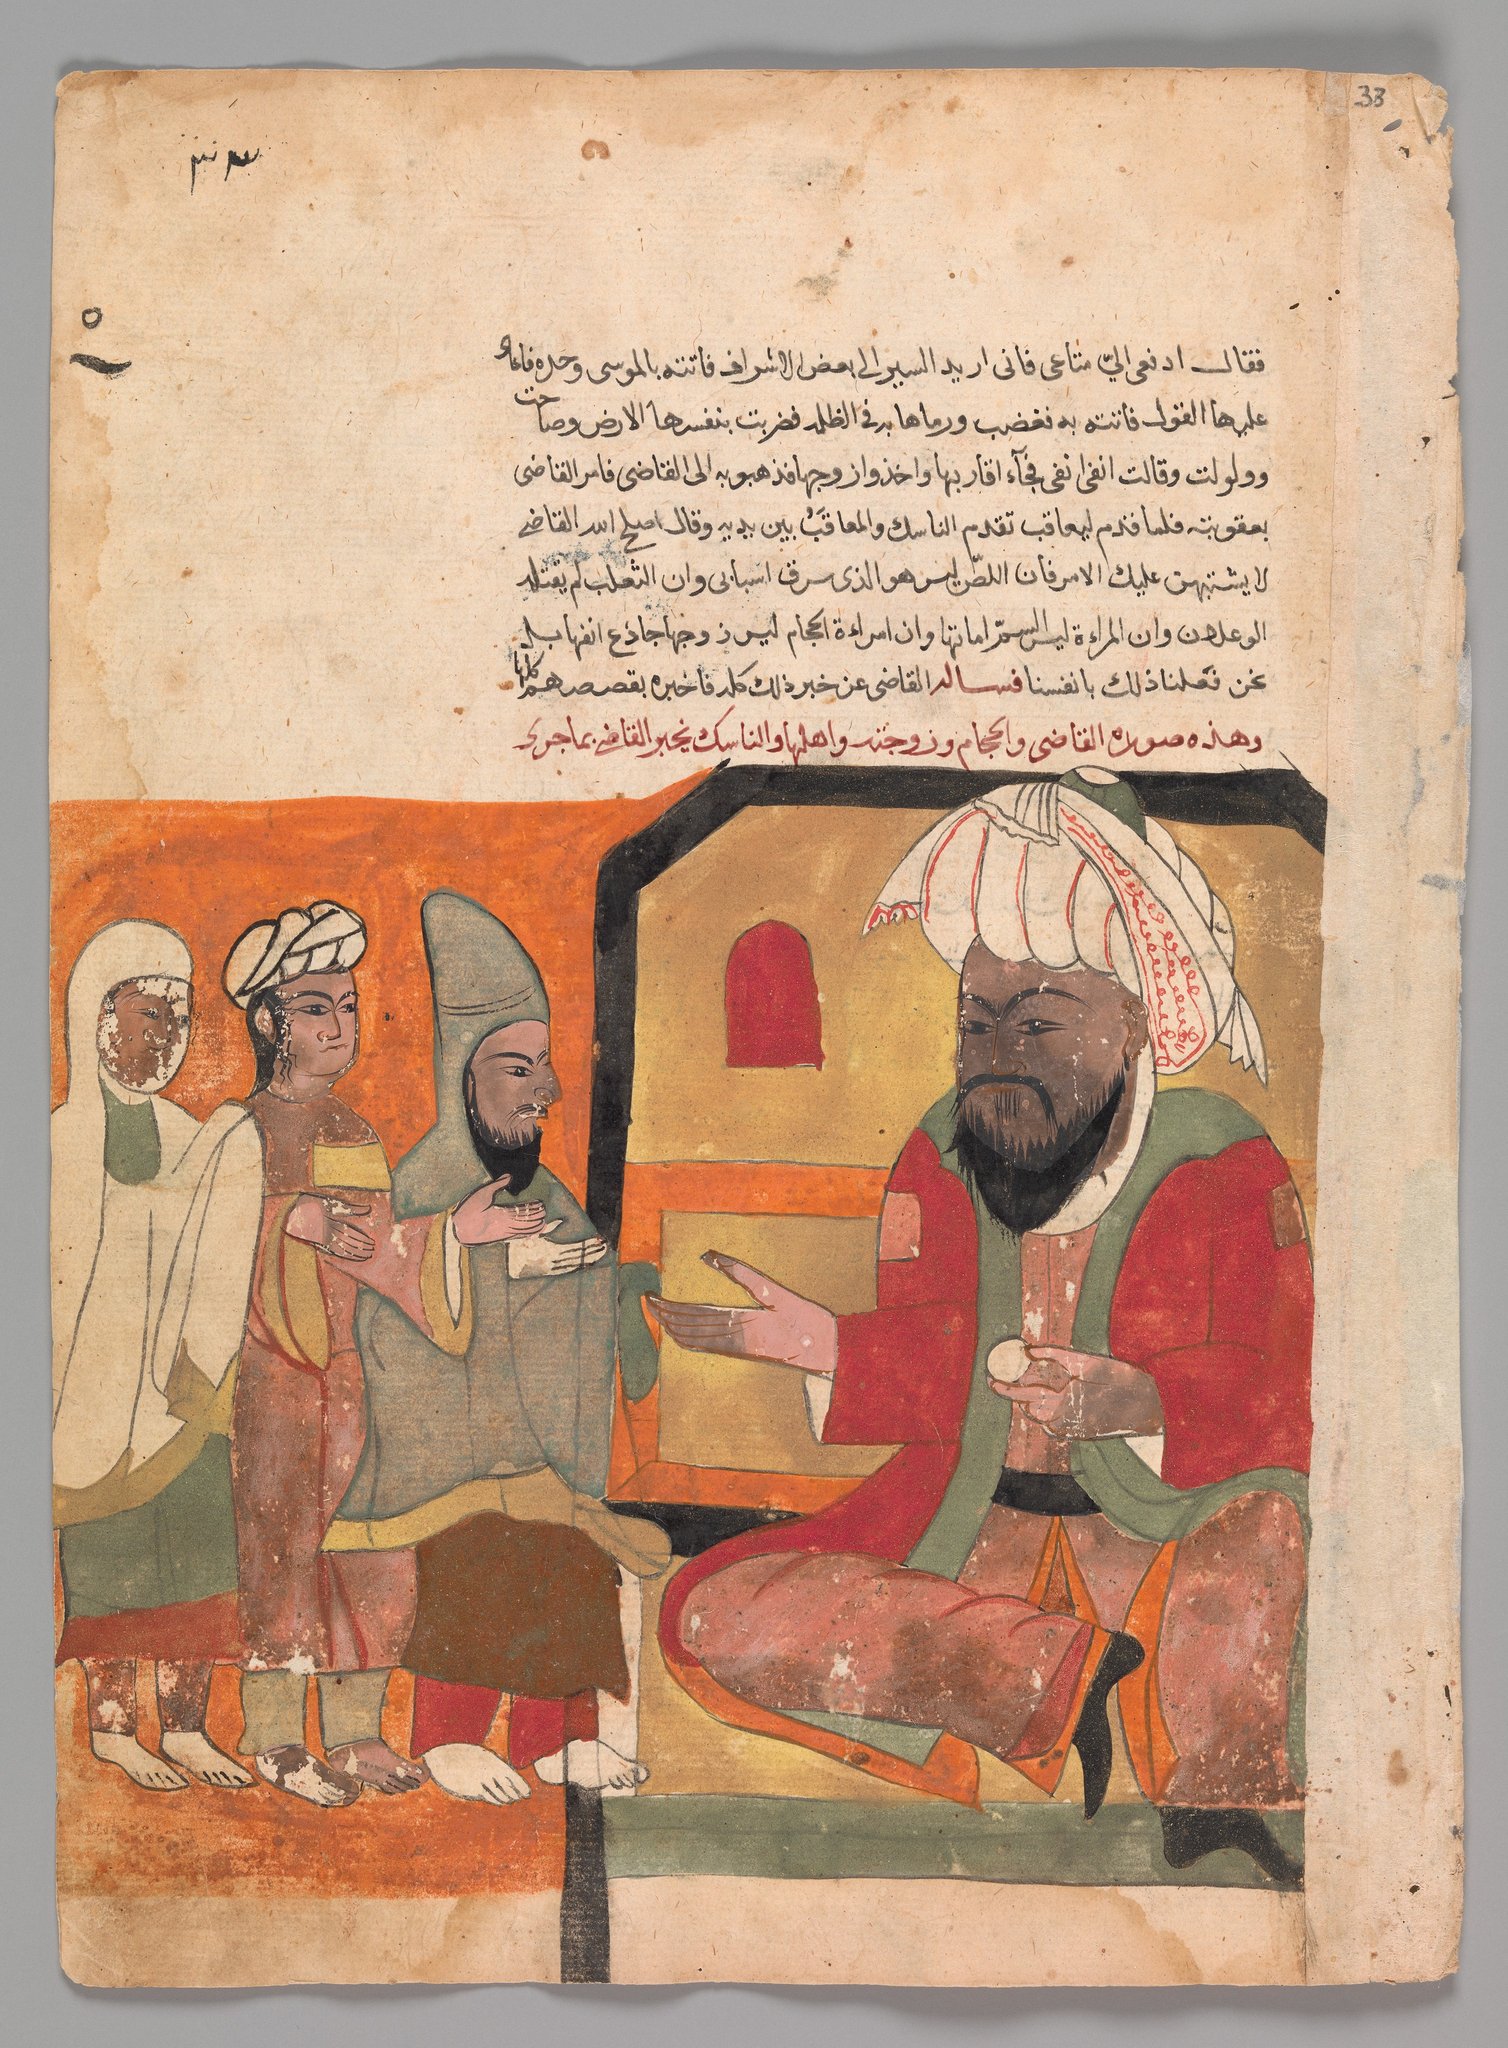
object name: folio from an illustrated manuscript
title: Folio from a Kalila wa Dimna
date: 1526-1550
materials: ink, paper, watercolor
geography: india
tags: men